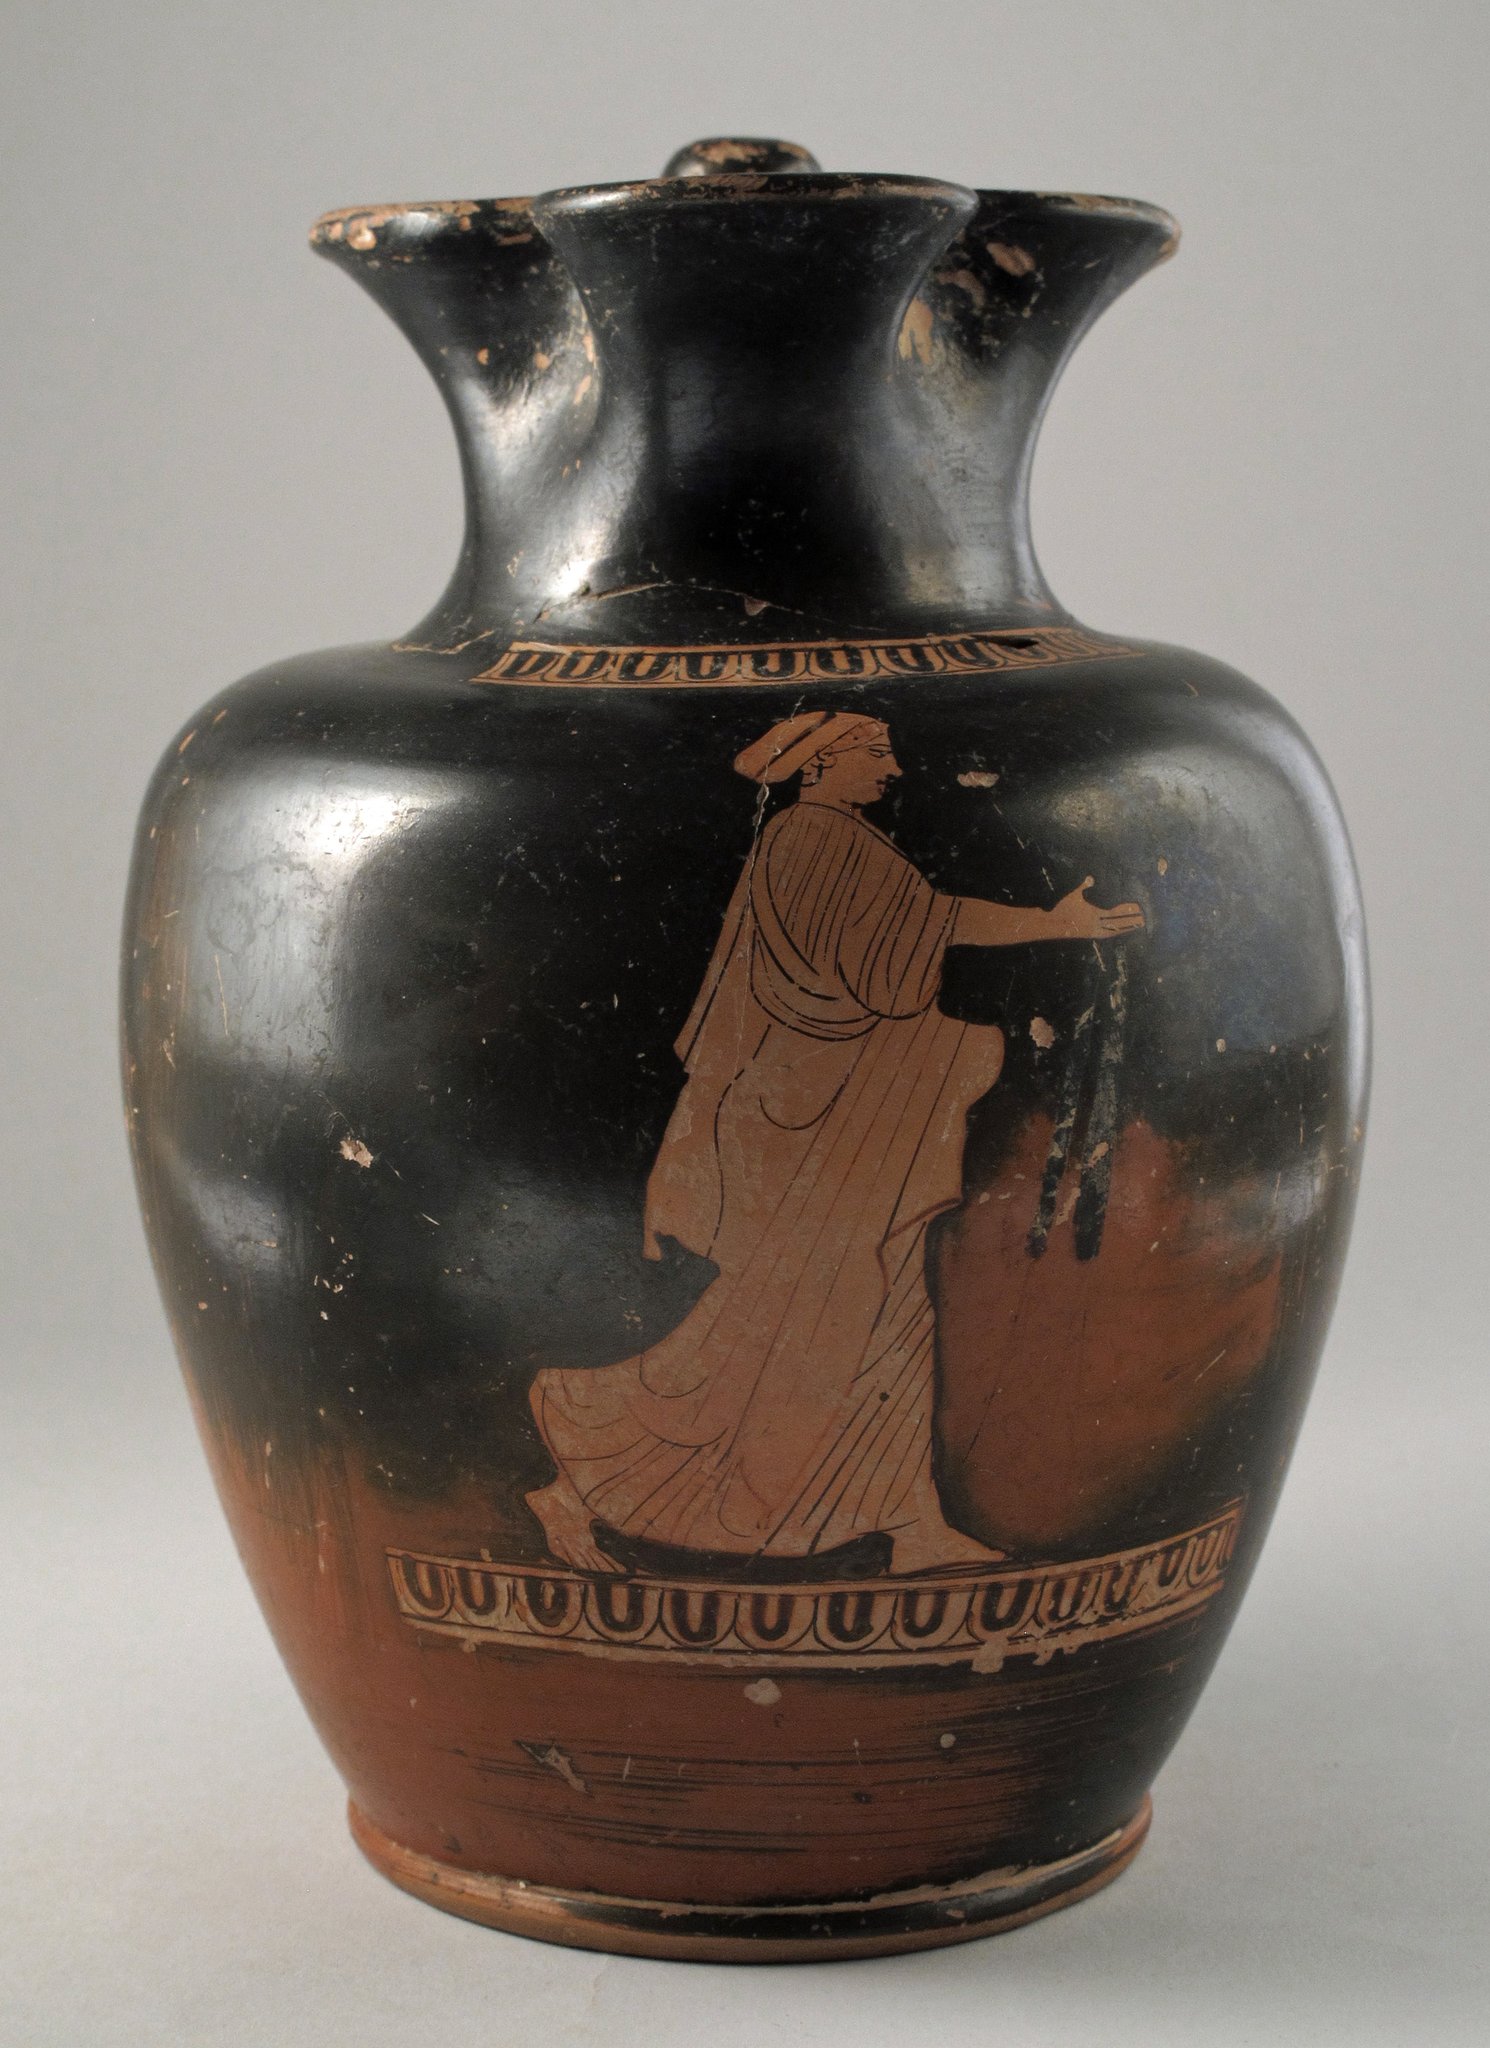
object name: oinochoe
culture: greek, attic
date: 440-430 BCE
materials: terracotta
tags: women